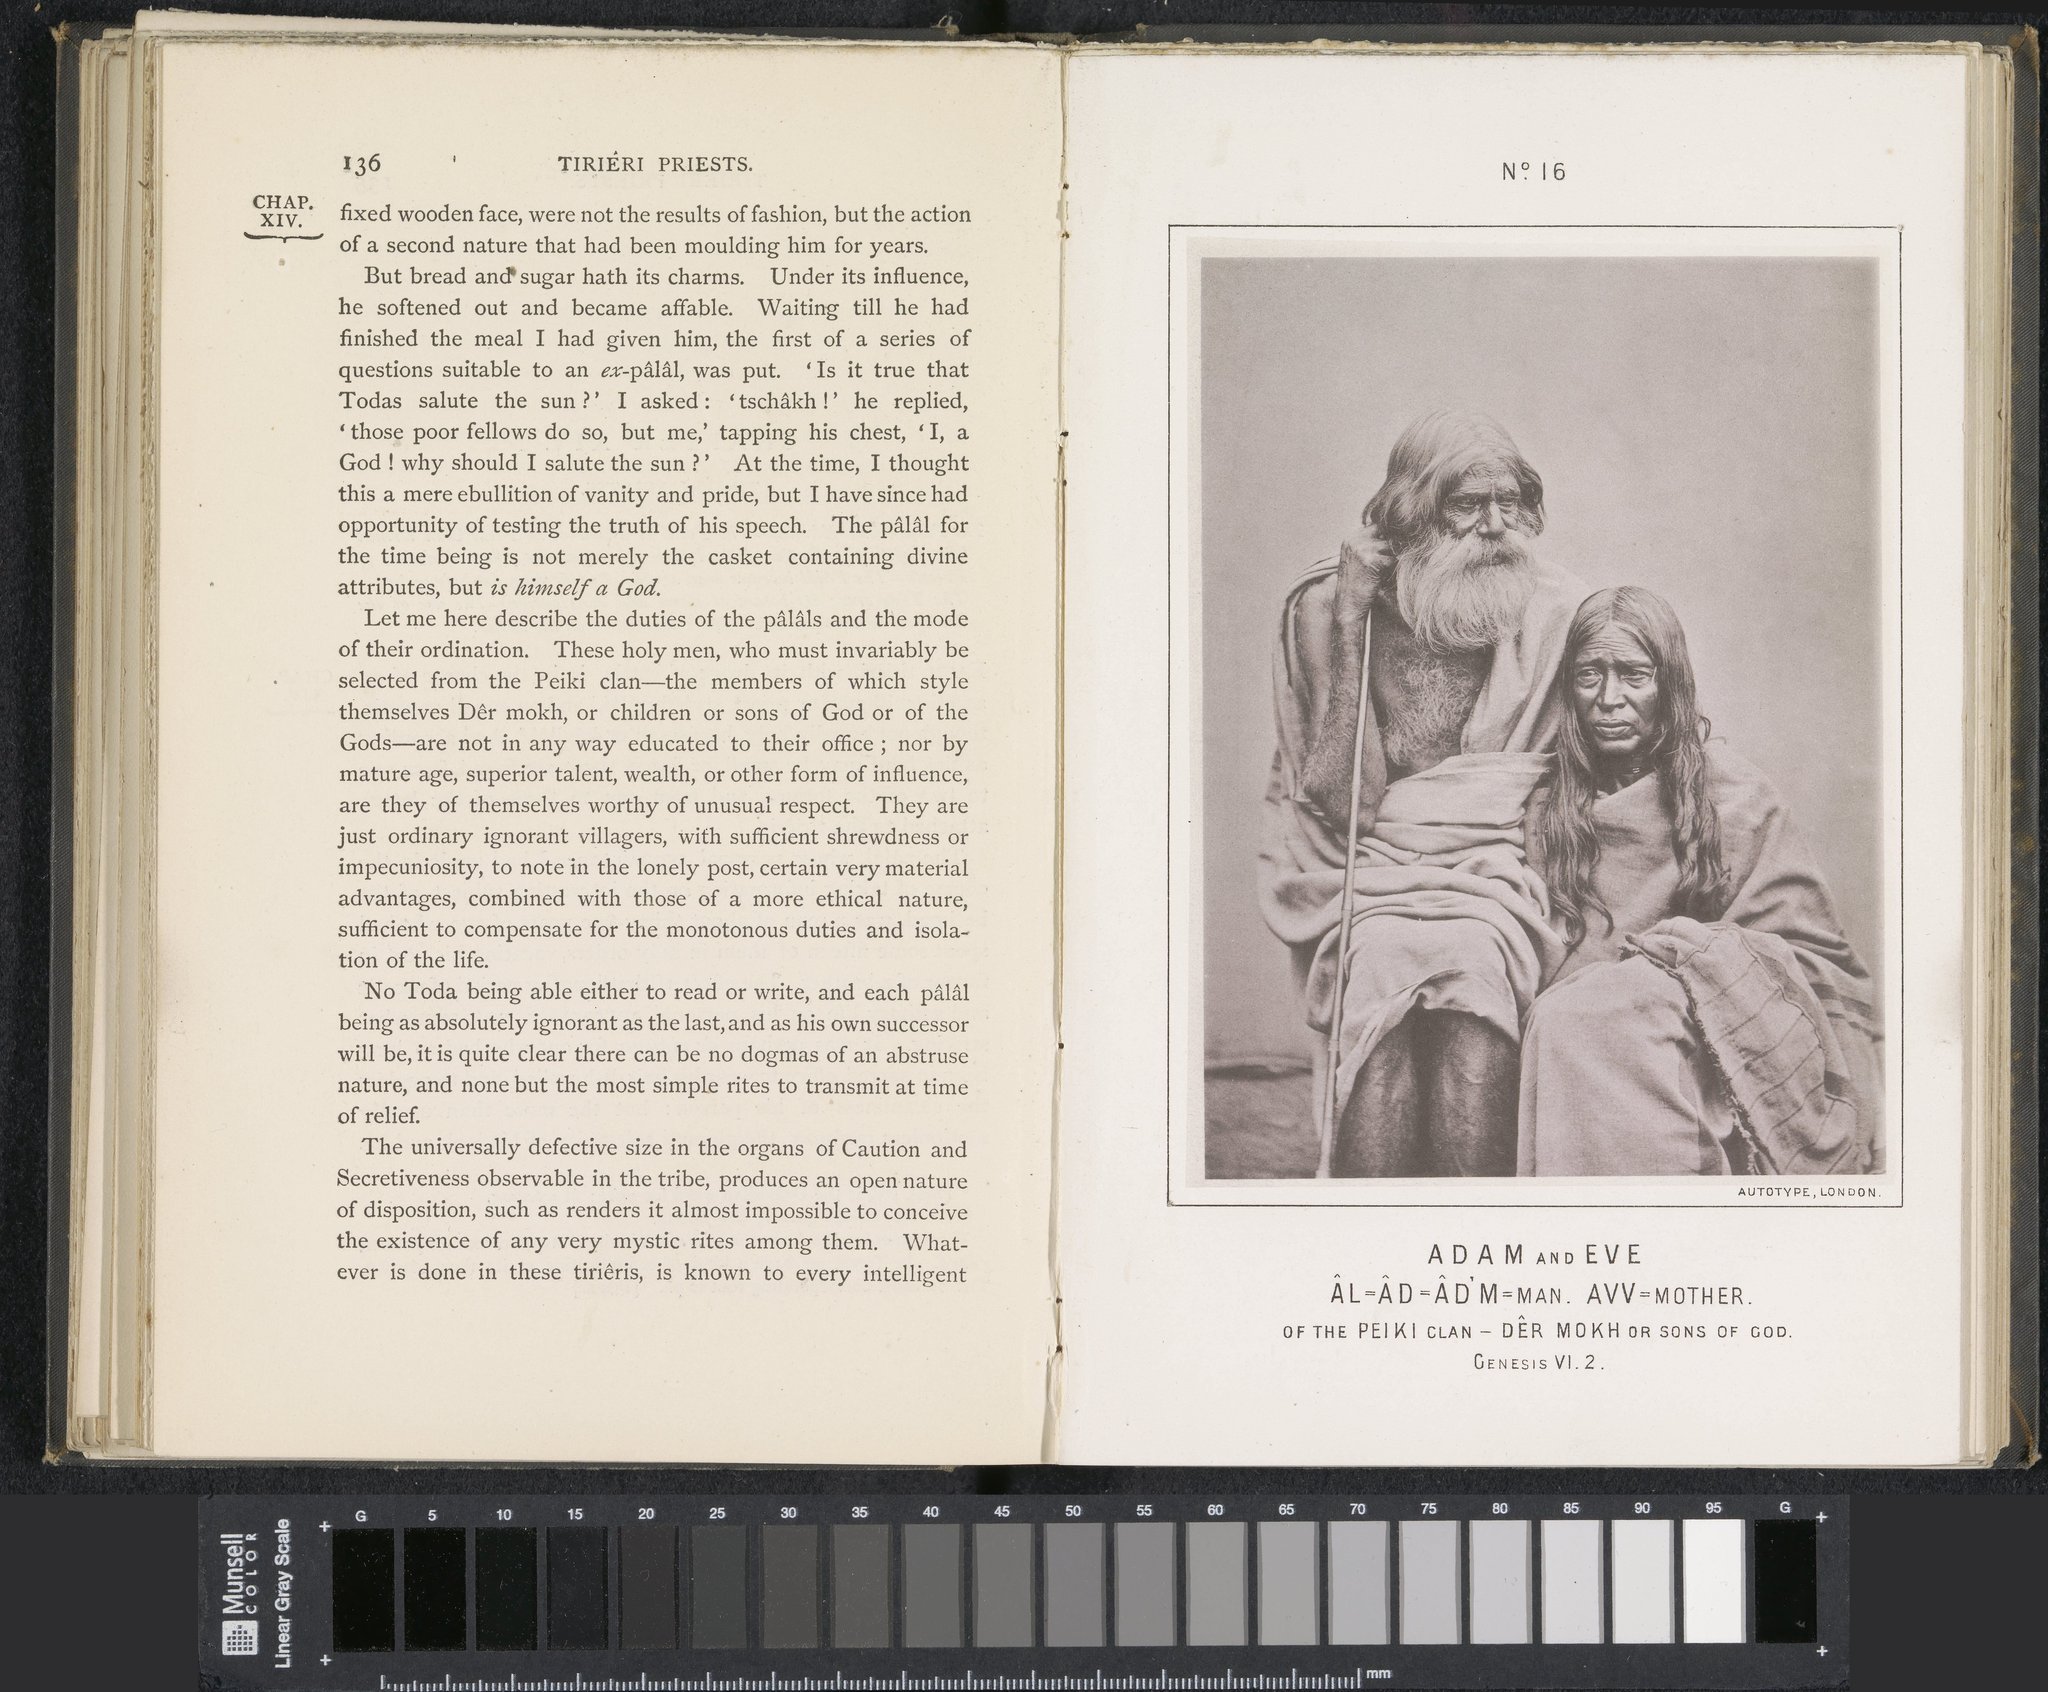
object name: page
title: Adam and Eve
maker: Anonymous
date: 1863-1873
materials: paper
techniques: photograph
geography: london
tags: old man, old woman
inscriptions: inscription: ‘Âl=Âd=Âd'm=man. Avv=mother of the Peiki clan - Dêr mokh or sons of God. Genesis VI. 2.’, number: ‘No. 16’